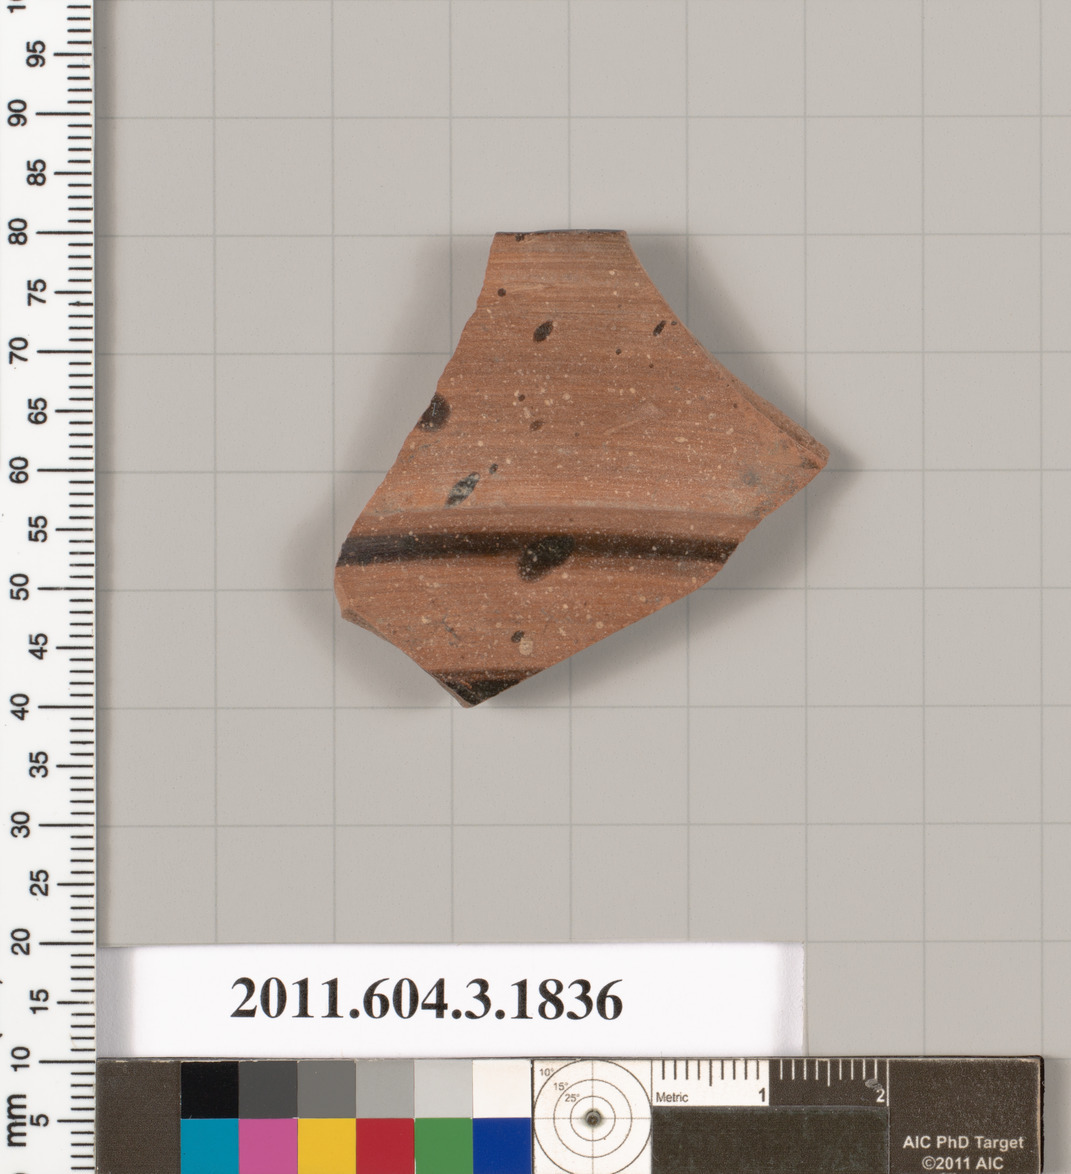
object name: kylix fragment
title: Terracotta fragment of a kylix: Lip cup (drinking cup)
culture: greek, attic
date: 560-525 BCE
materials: terracotta